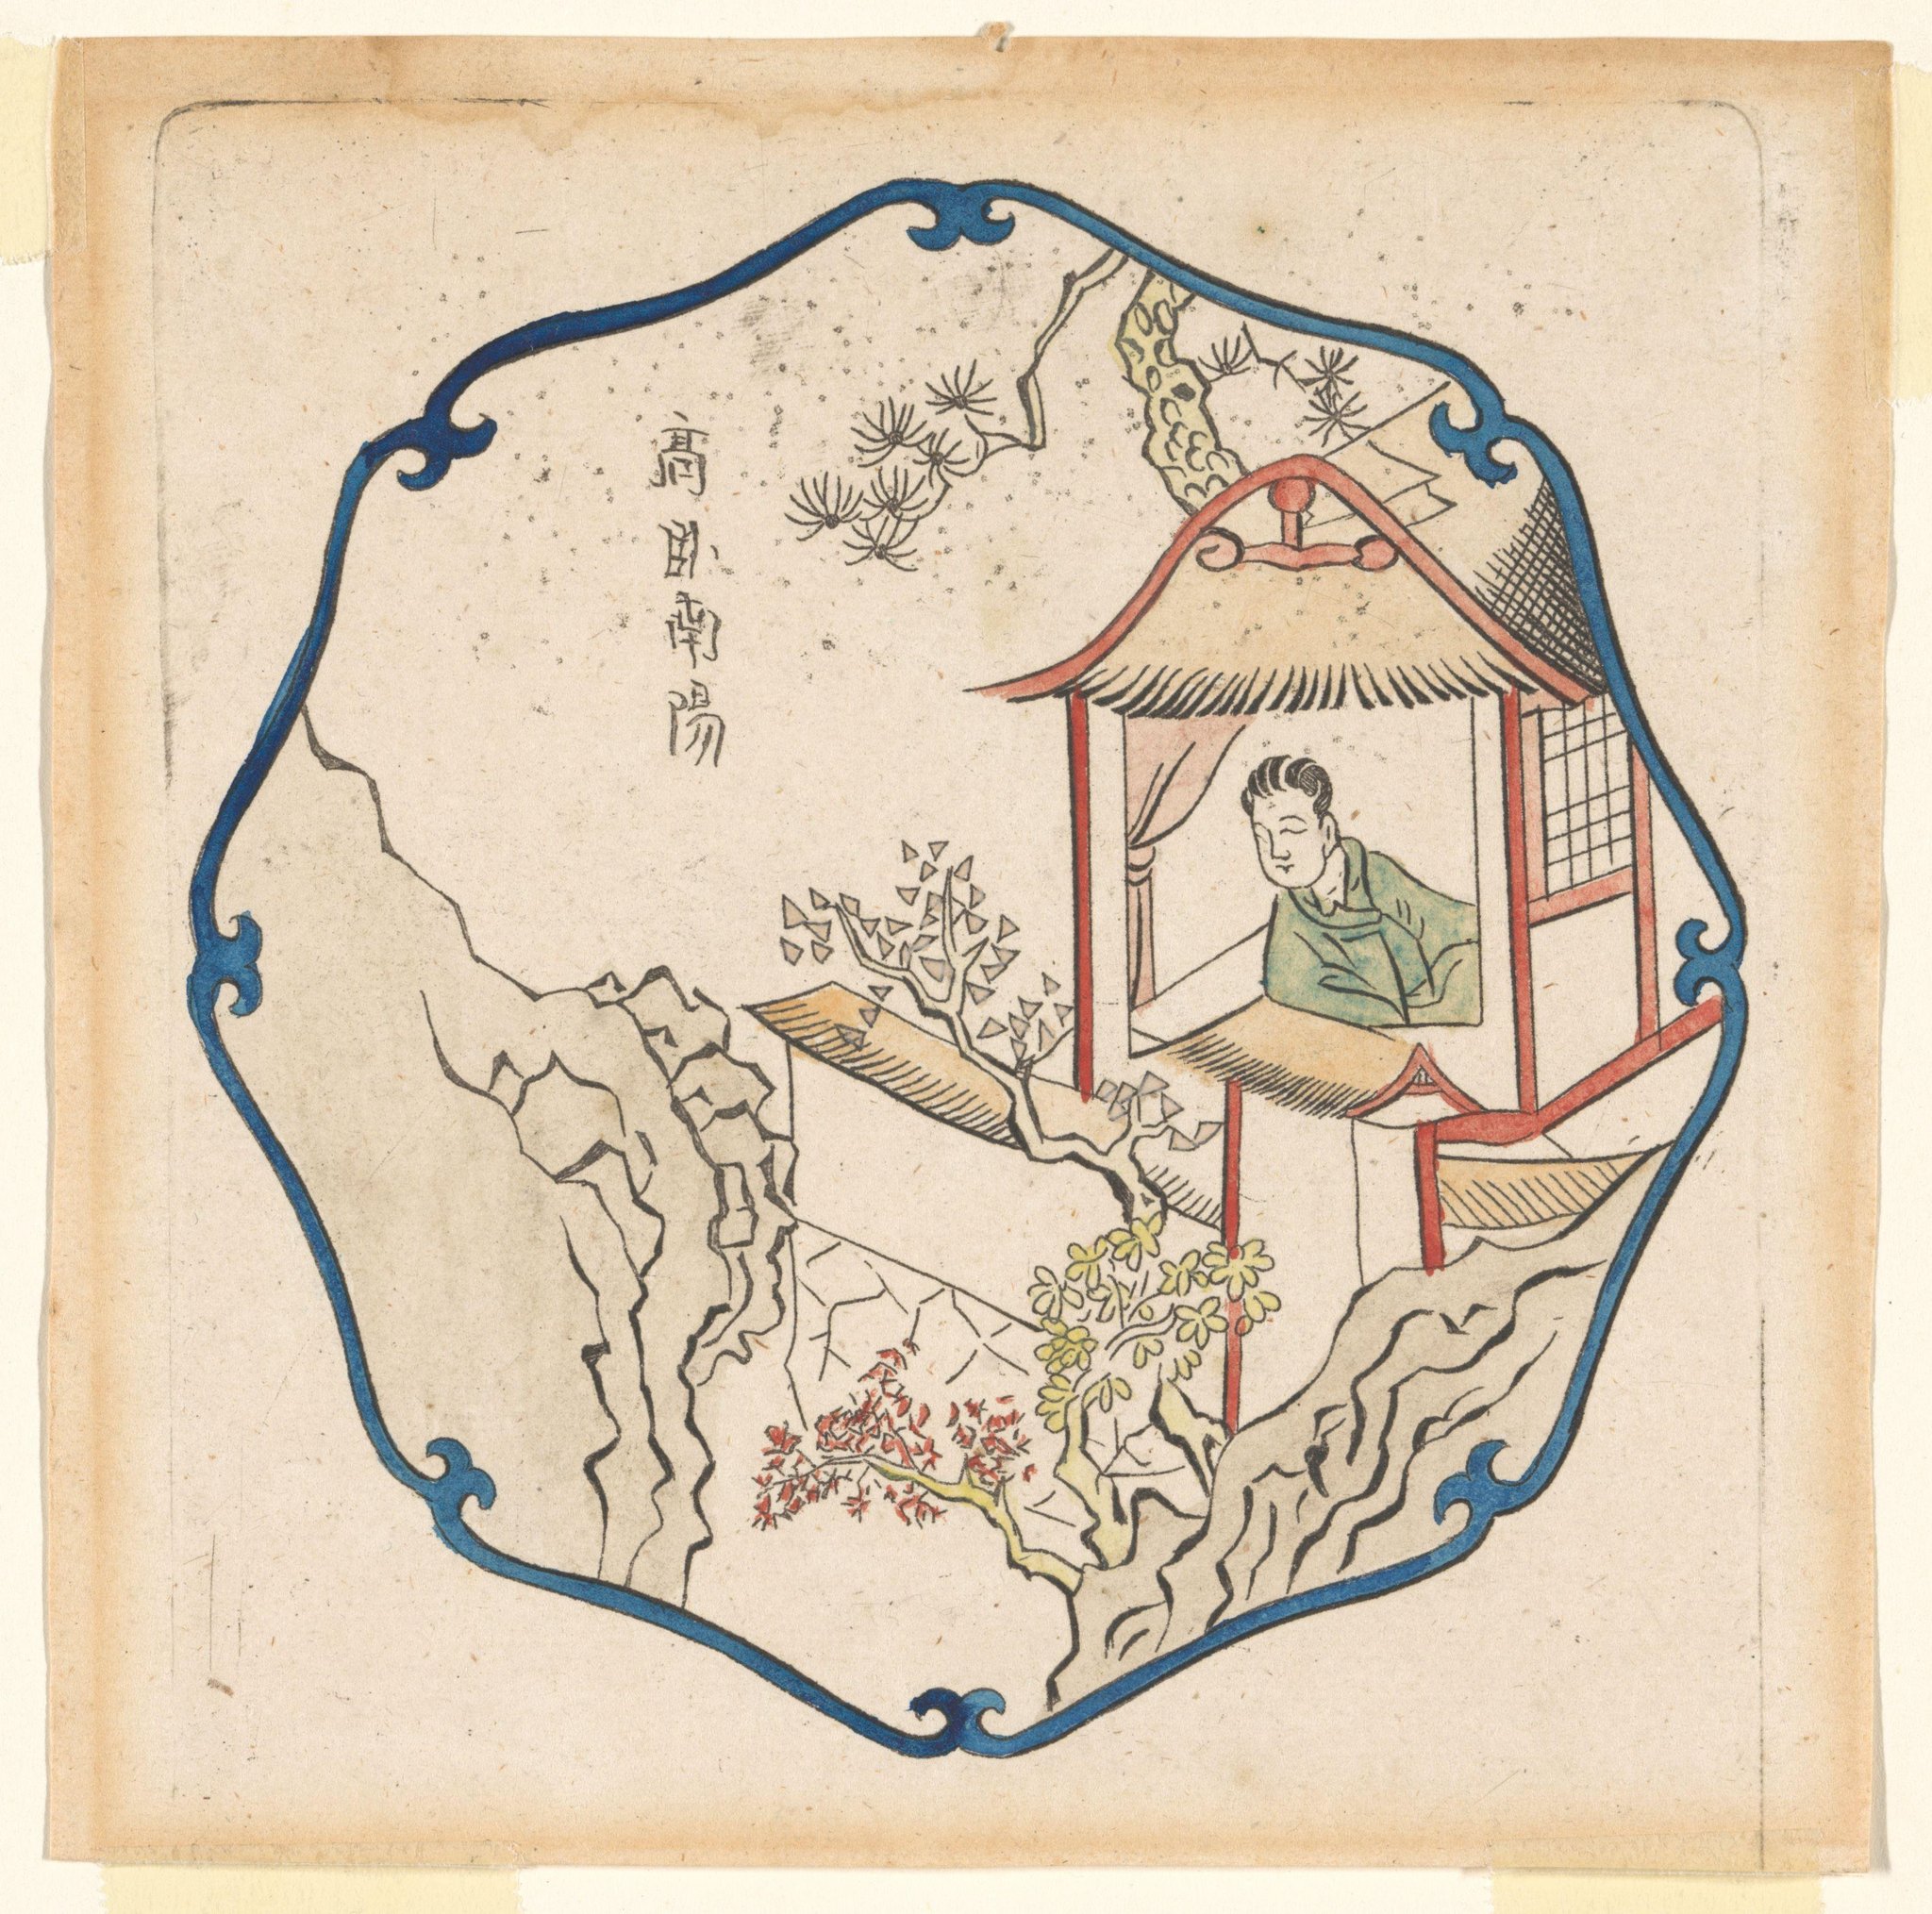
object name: print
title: Carefree life in Hsin-yang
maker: pieter schenk (i)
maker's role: print maker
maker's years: 1660-1711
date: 1702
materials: paper, watercolor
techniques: etching, hand coloring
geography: amsterdam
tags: chinese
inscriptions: collector's mark: Lugt 2228, collector's mark: Lugt 2760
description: Schenk the elder depicted T’ao Ch’ien looking over his flower garden, enjoying his retirement from civic service. These etchings are two of eight roundels illustrating Chinese history, which Schenk copied from Chinese woodcuts. Using watercolour, these handcoloured prints mimick the chinoiserie designs on Meissen and Delftware, such as the vase and beer tankard also on display.